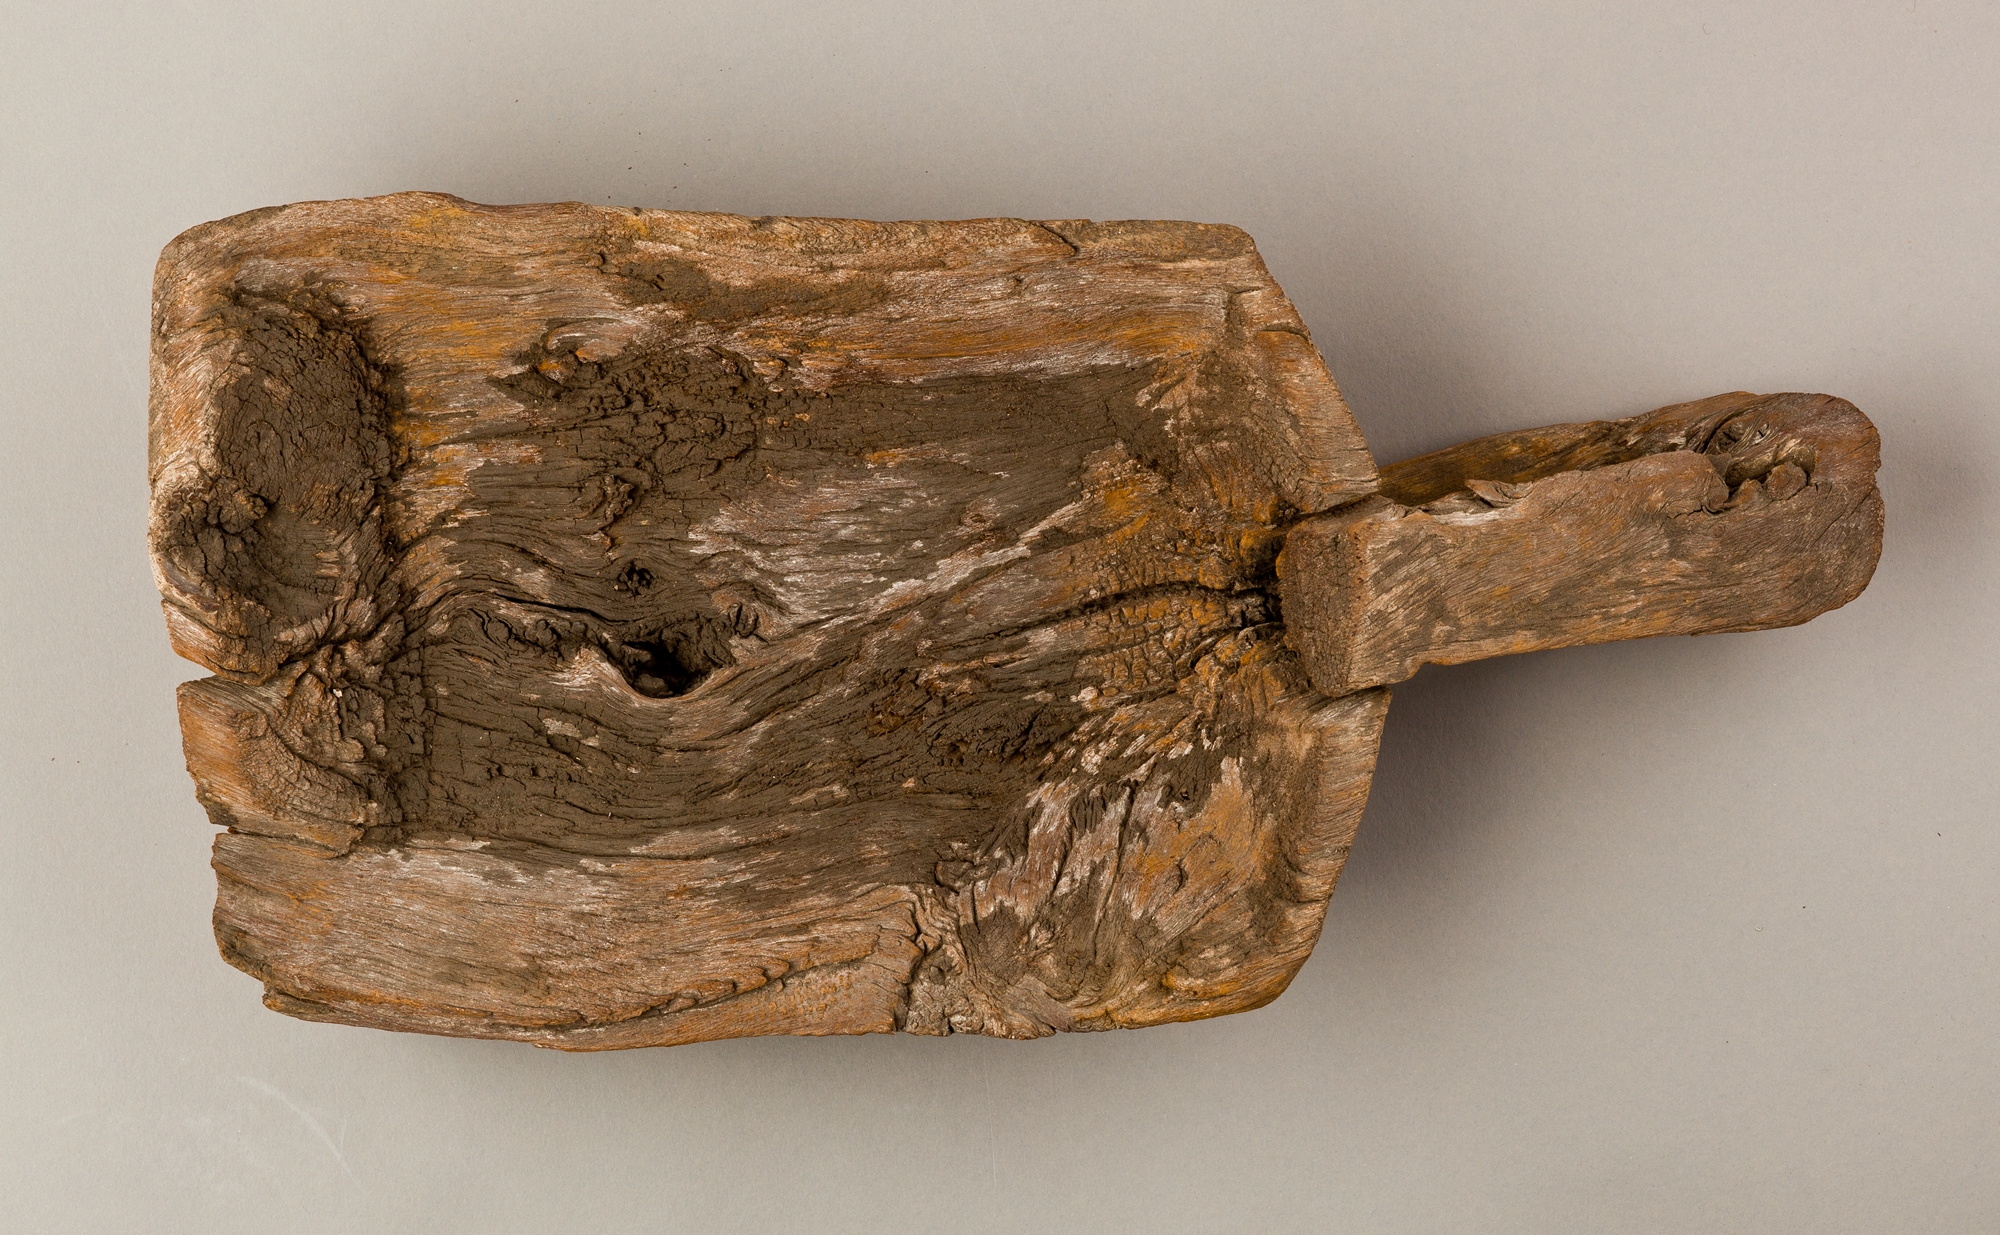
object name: ladle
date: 3100-2649 BCE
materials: wood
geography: egypt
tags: ladles